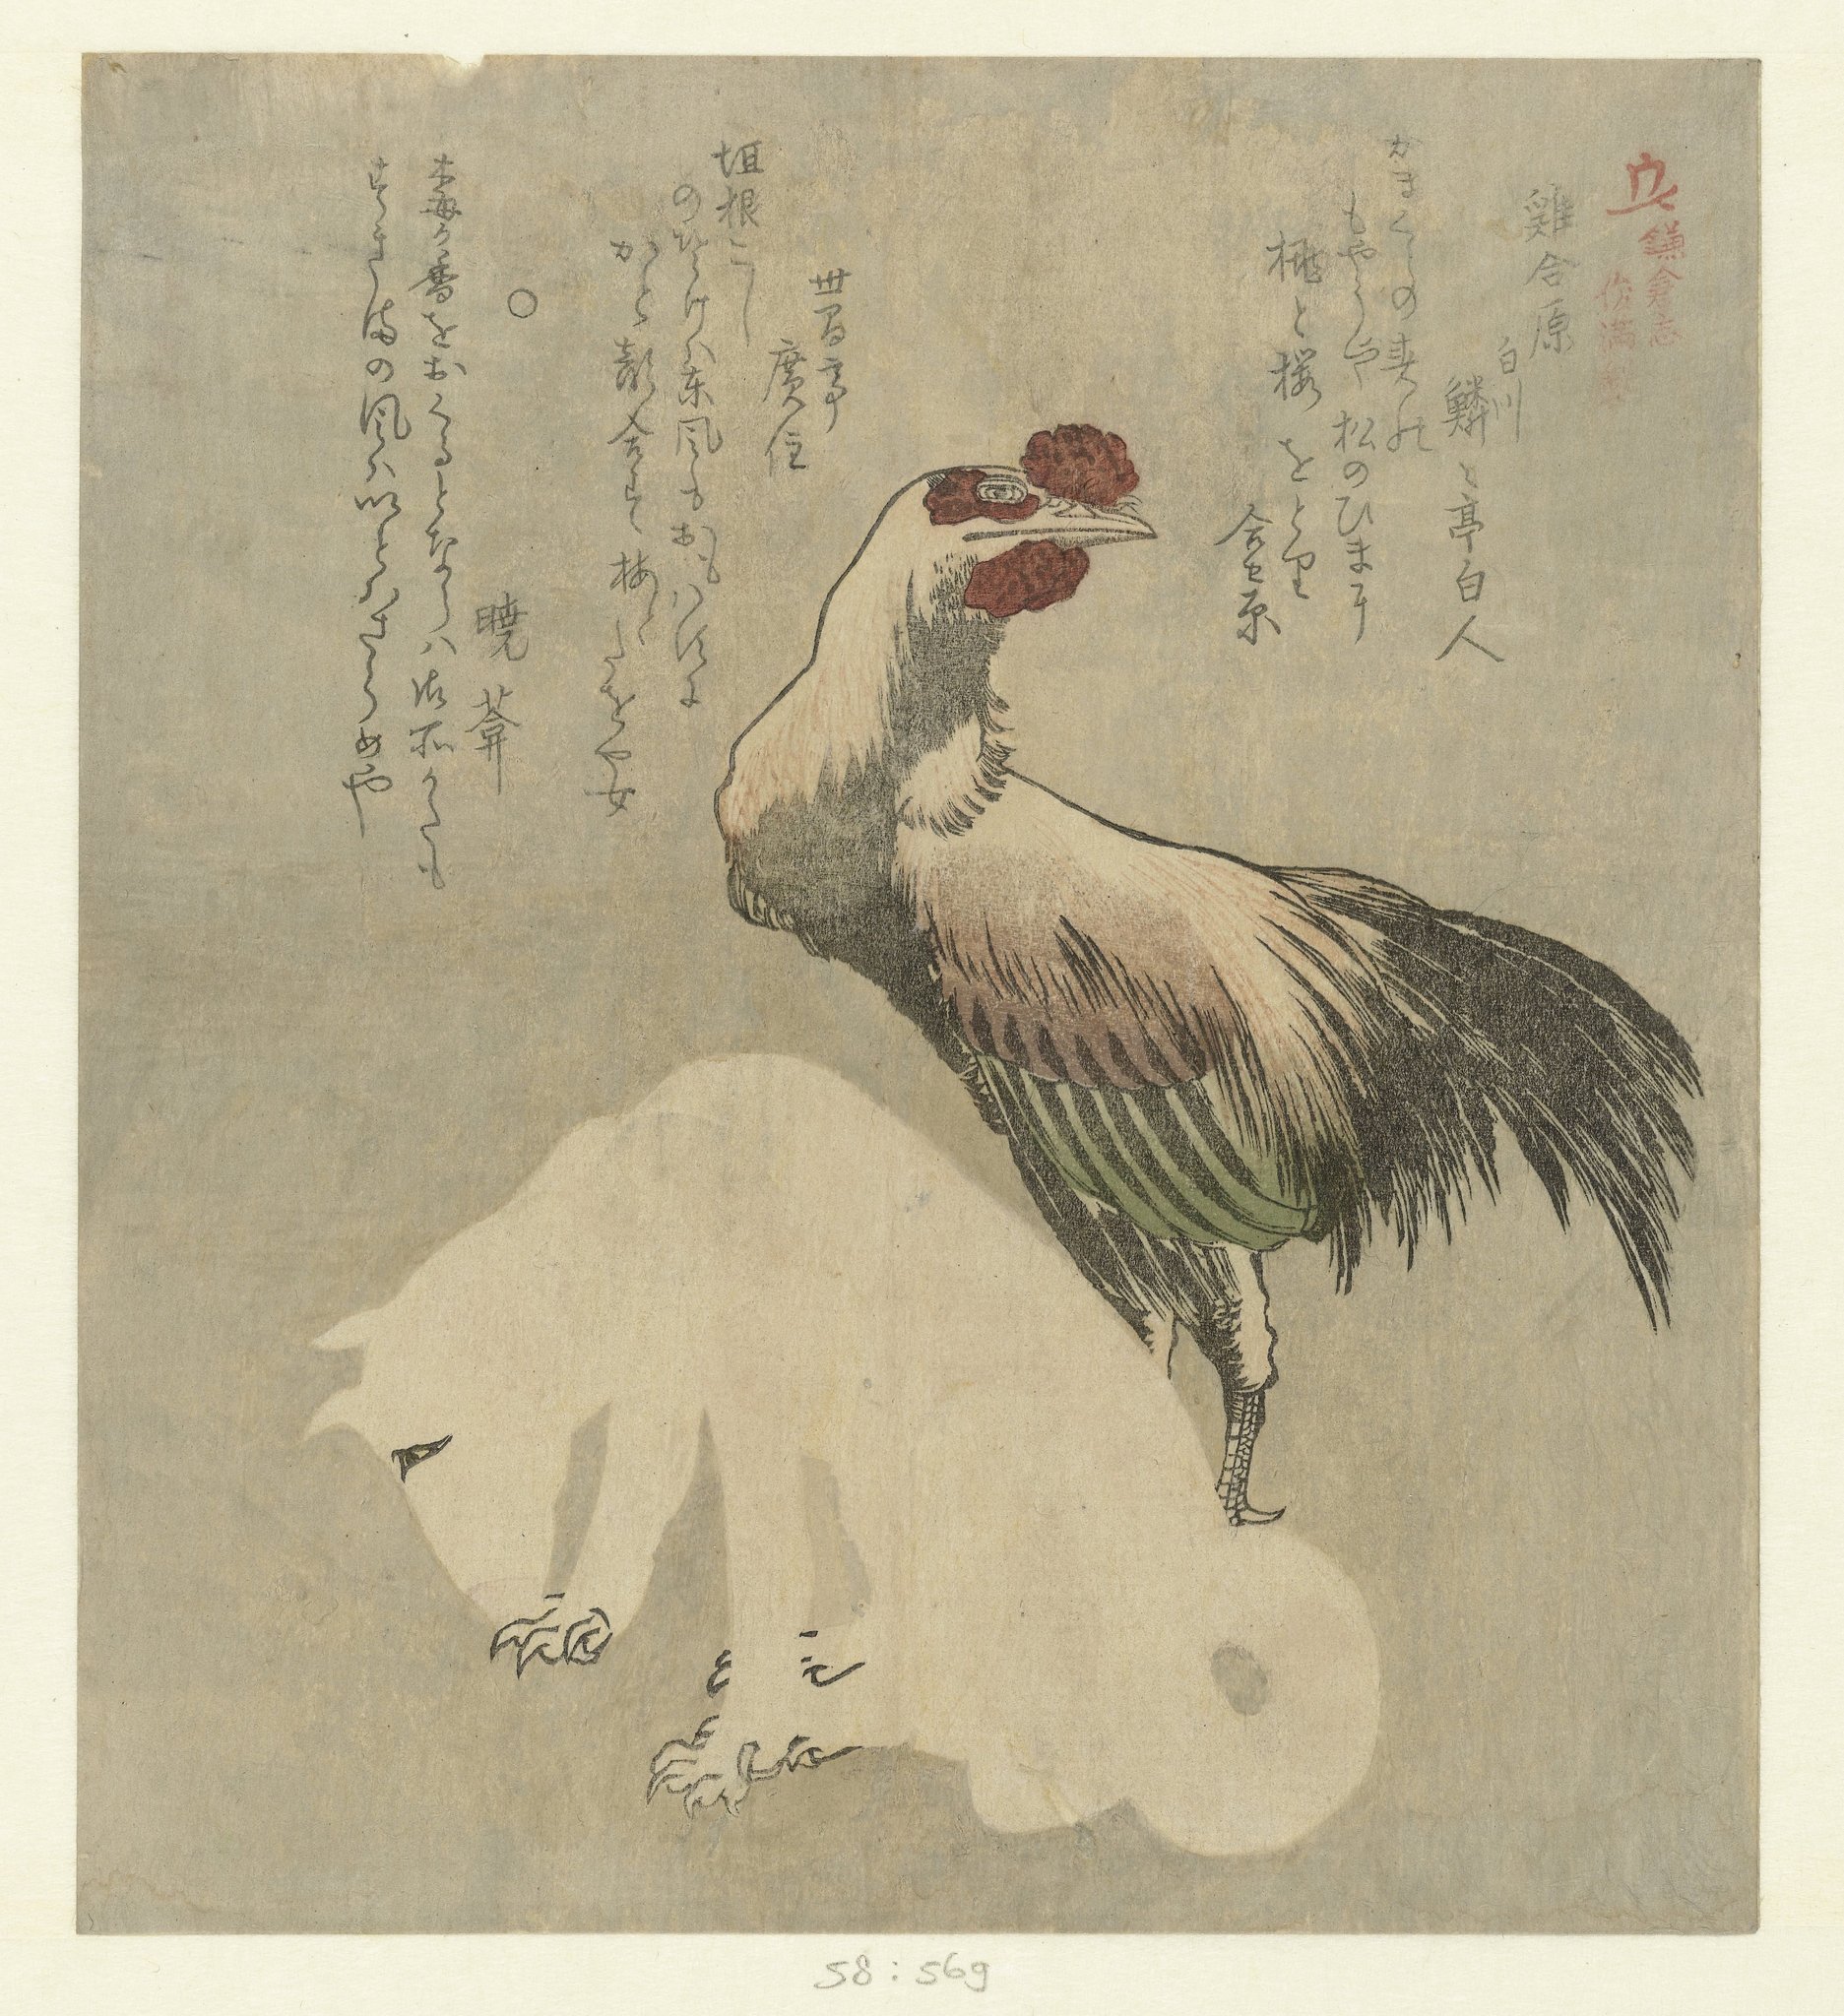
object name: surimono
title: Cock and Dog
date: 1816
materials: paper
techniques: blind stamped, woodcut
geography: japan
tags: fowl (cock, hen, chicken, etc.), dog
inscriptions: collector's mark, passe-partout, bottom left, printed: JABdH with a rooster.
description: Een surimono is een luxe uitgevoerde prent waarop beeld met één of meerdere gedichten gecombineerd is. Bij het drukken van een surimono werd vaak gebruik gemaakt van dikker papier, blinddruk en metaal pigmenten, zoals koper- en zilverpoeder. De prenten werden vaak in opdracht van dichters gemaakt en als exclusief geschenk aan vrienden en relaties gegeven.